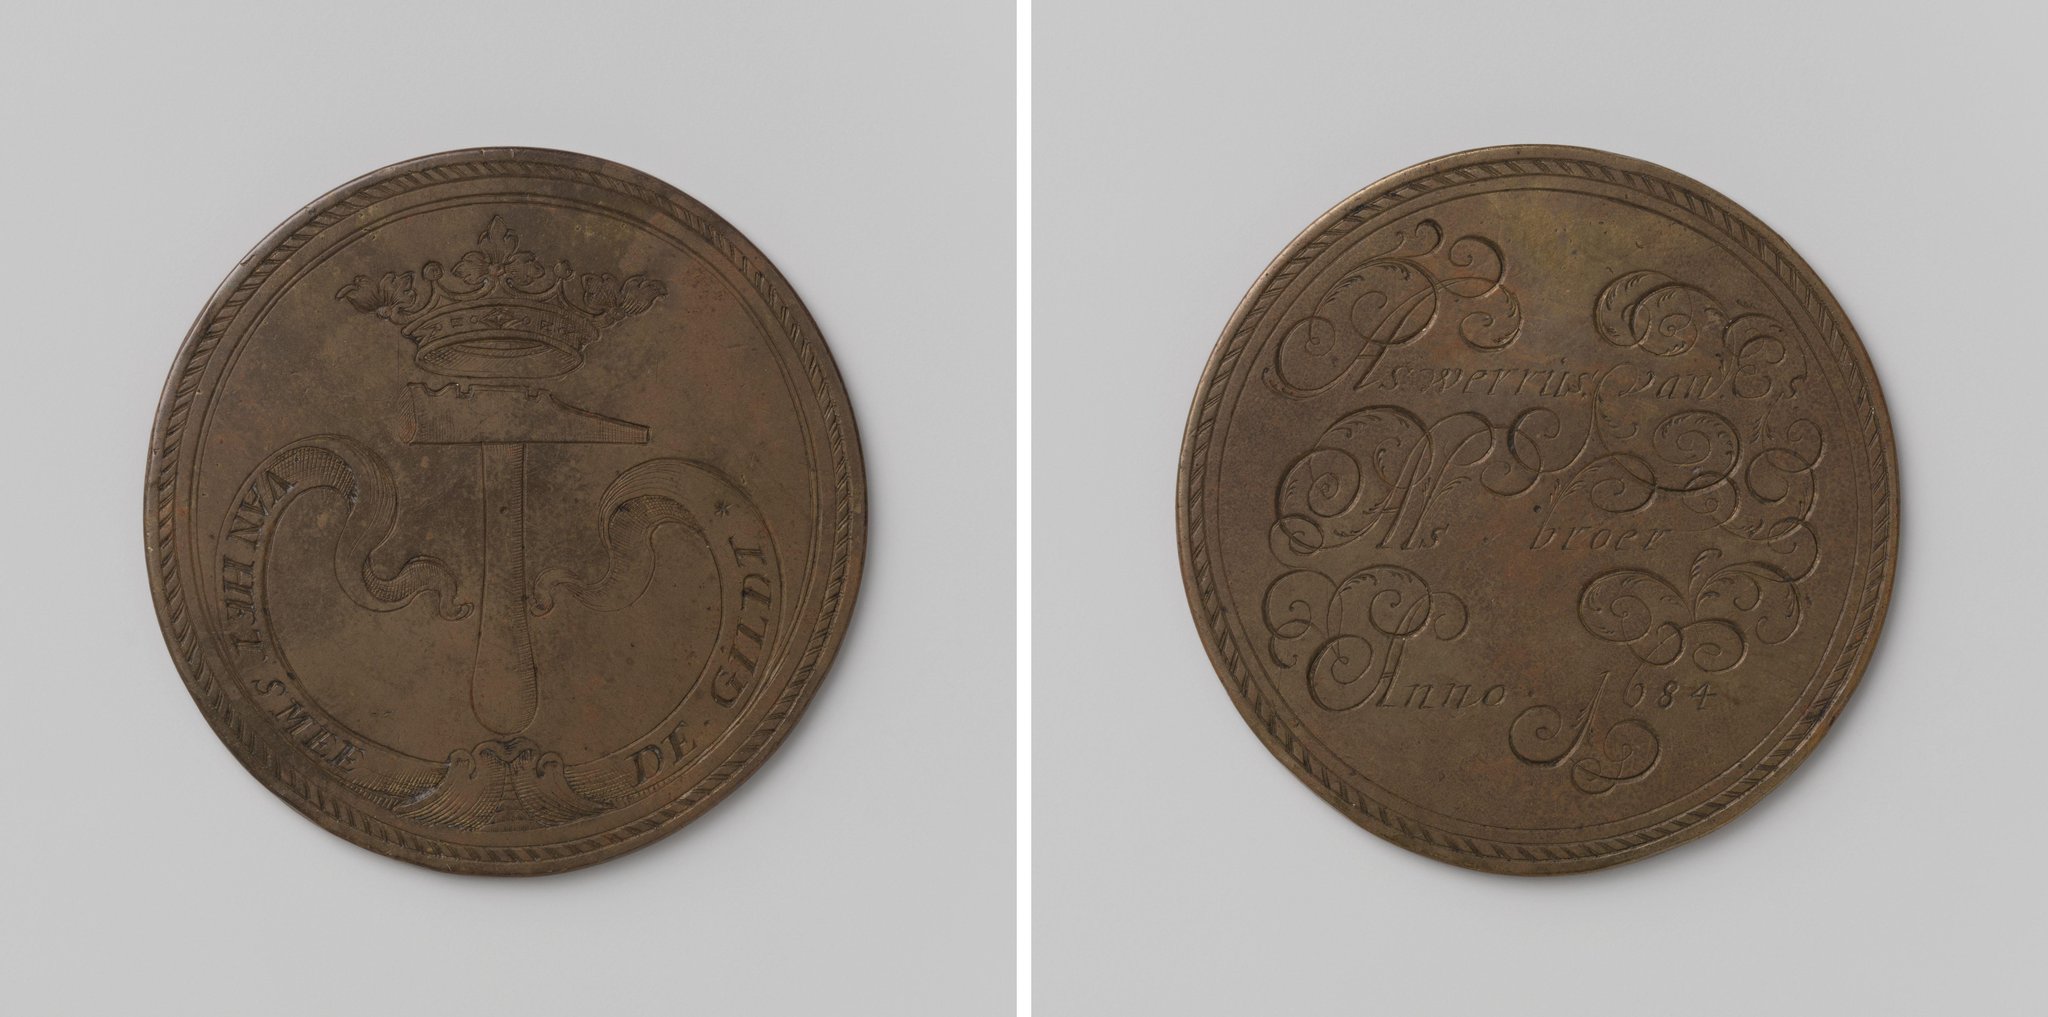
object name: medal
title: Gildepenning van het Smedengilde te Utrecht, op naam van Aswerrus van Es.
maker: Anonymous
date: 1684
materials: brass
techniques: engraving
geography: utrecht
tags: utrecht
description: Messing penning. Voorzijde: gekroonde voorslaghamer boven krullend lint met opschrift. Keerzijde: opschrift